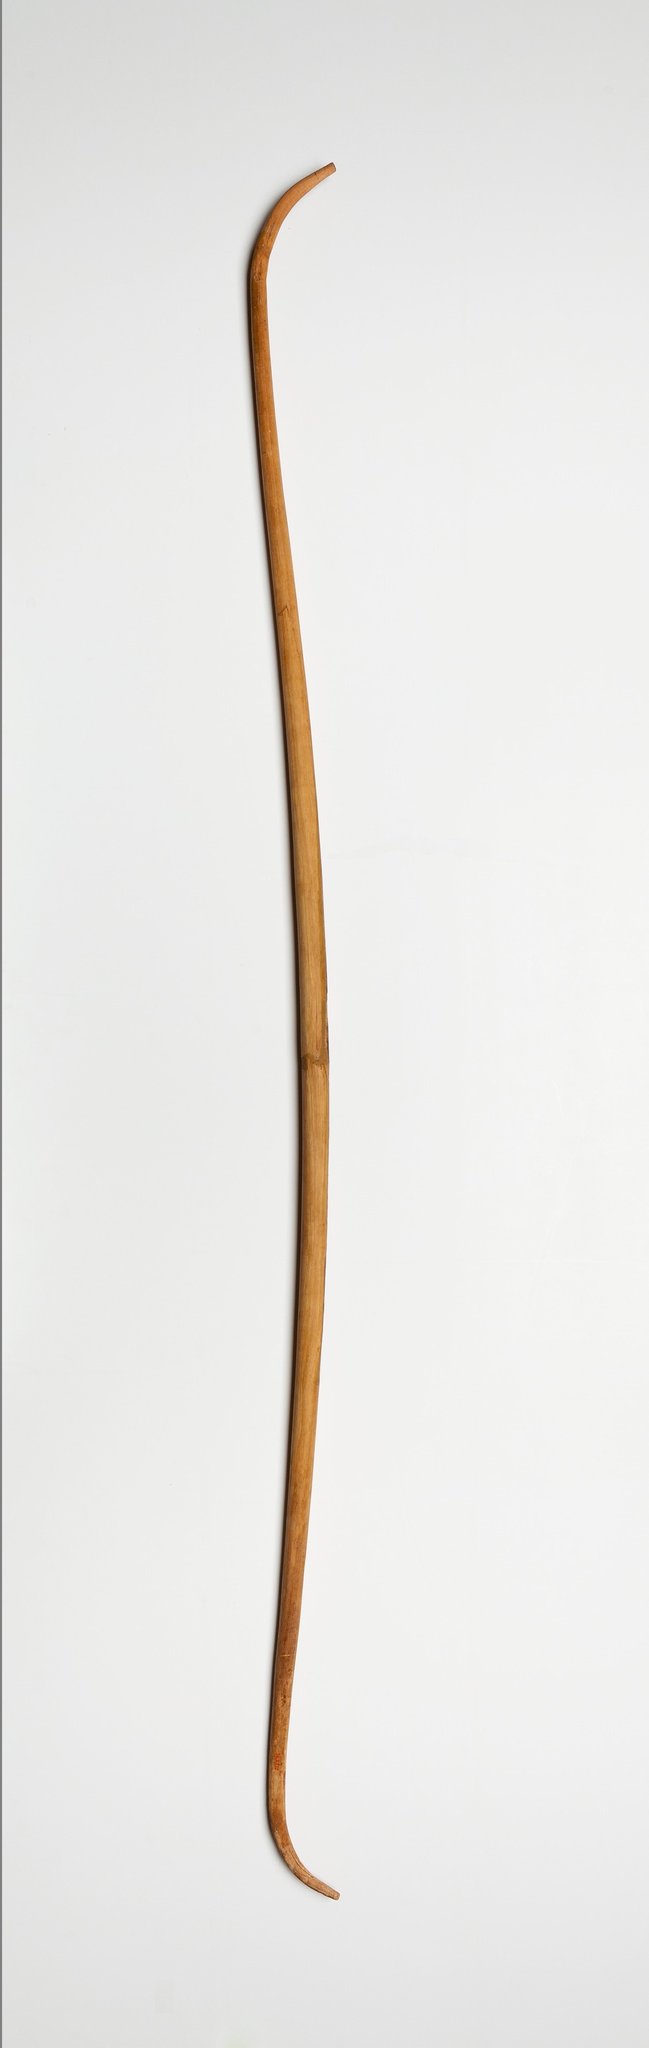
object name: bow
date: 1492-1473 BCE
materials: wood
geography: egypt